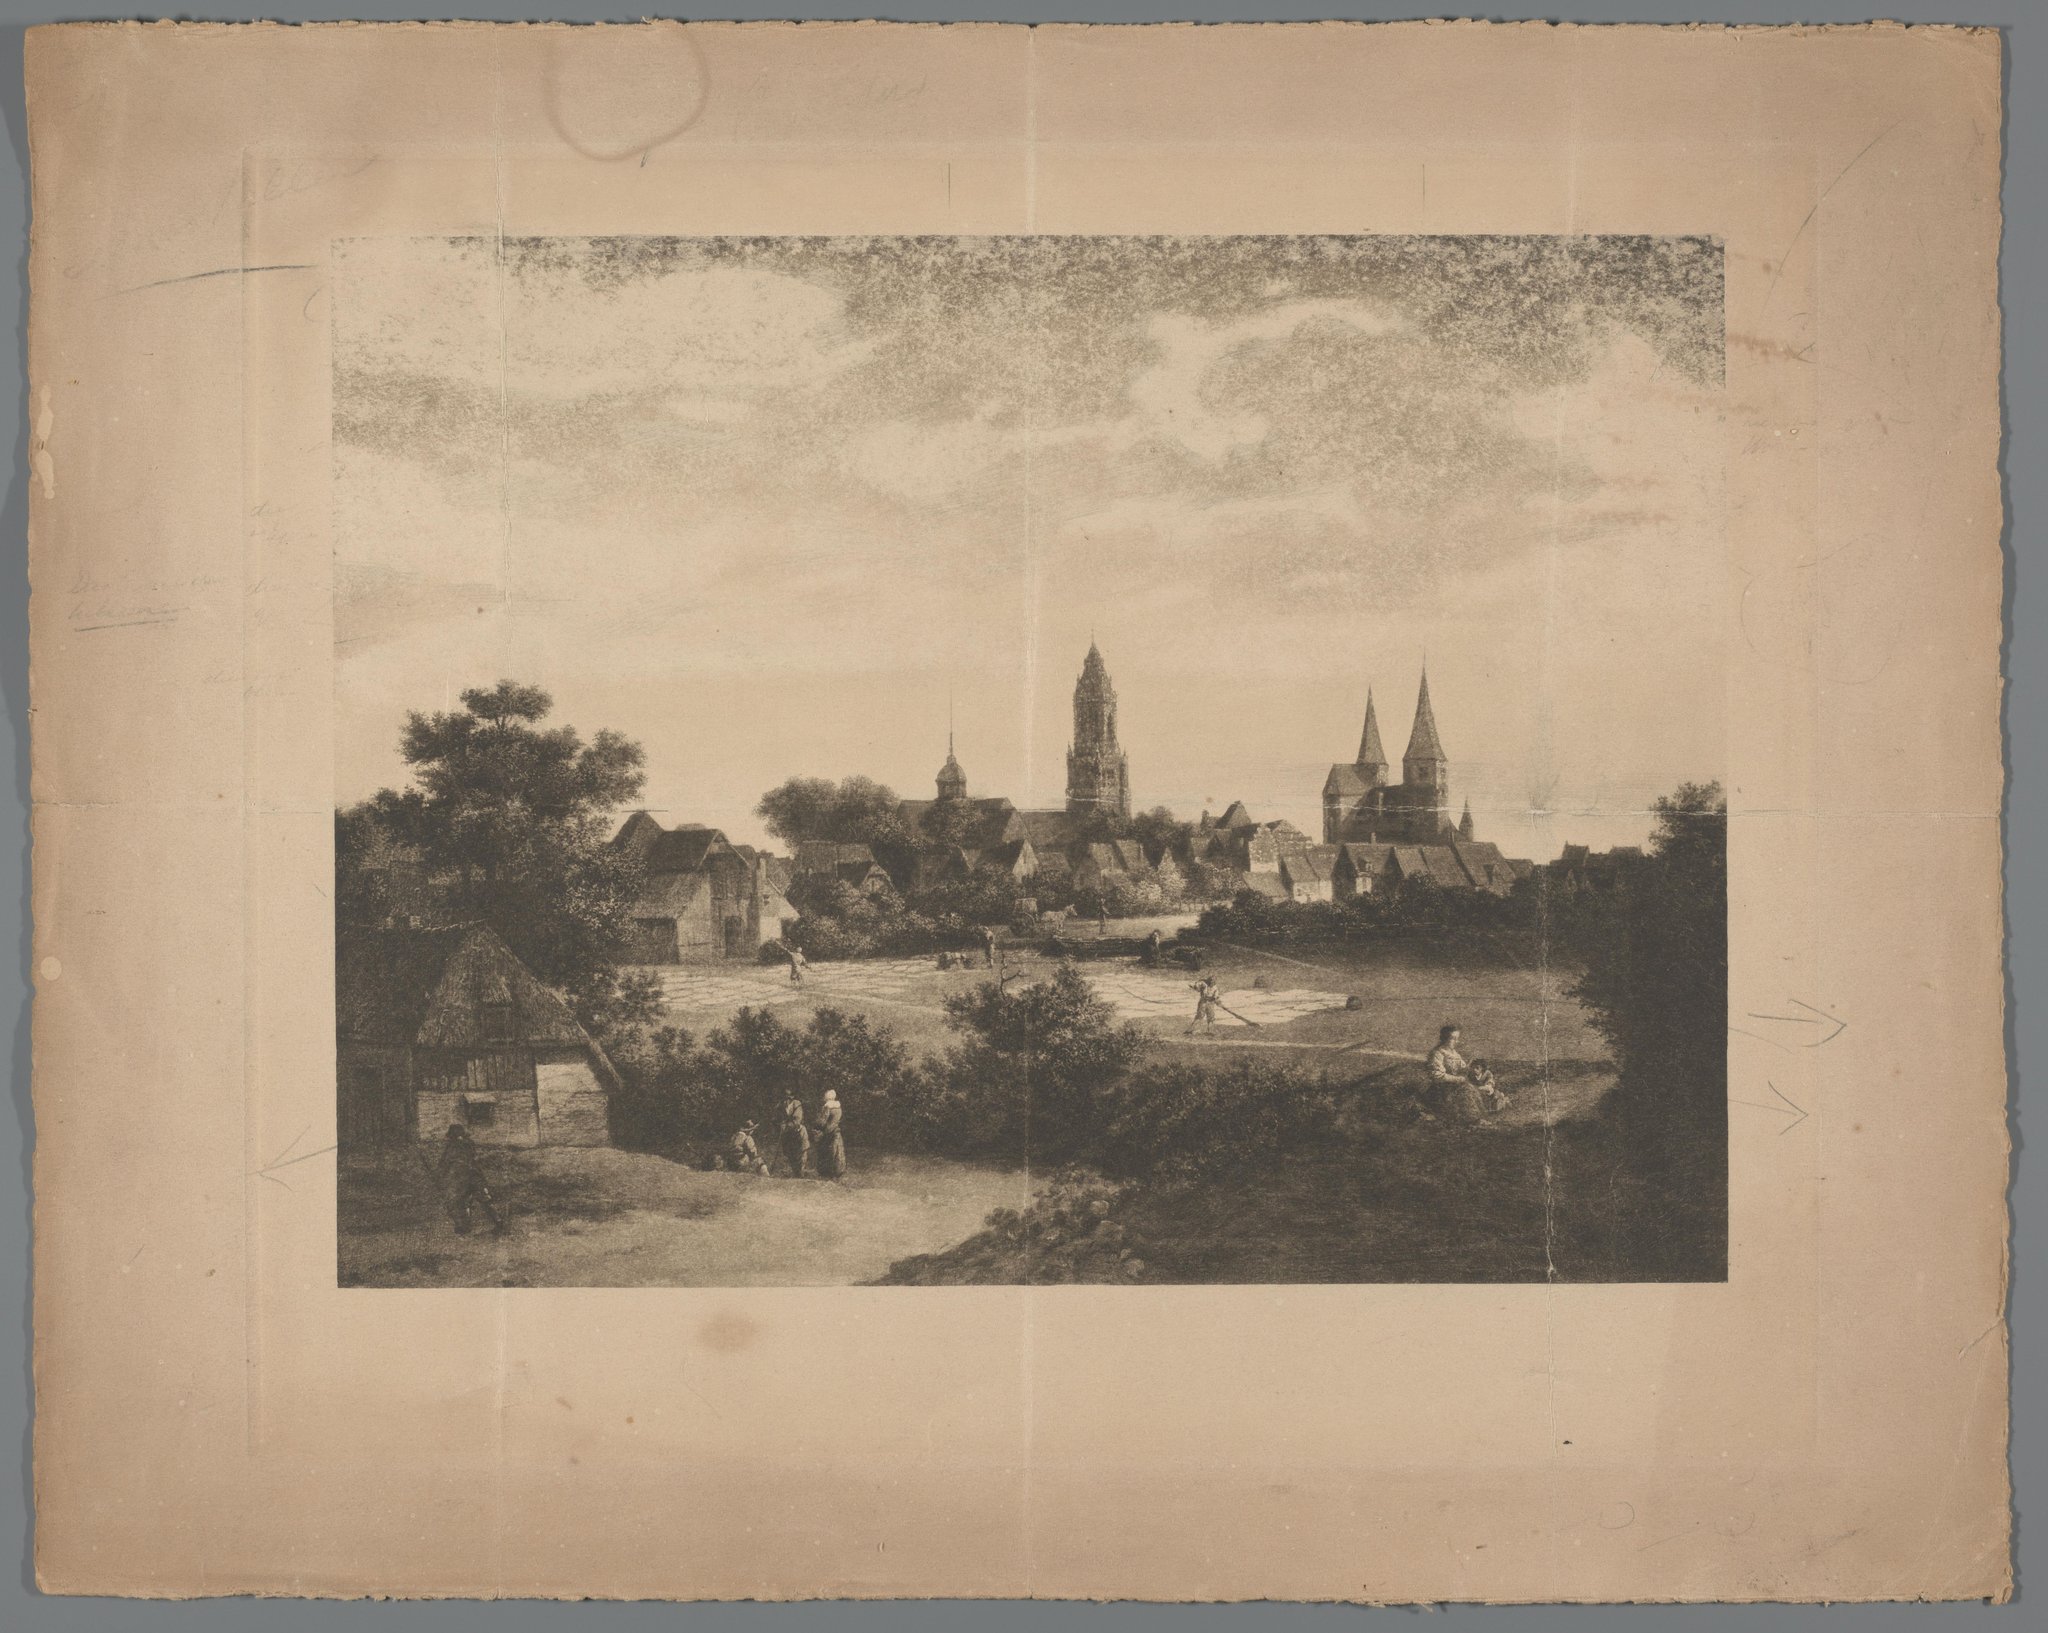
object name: photomechanical print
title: Reproductie van een schilderij met stadsgezicht en een bleekveld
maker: Anonymous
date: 1880-2023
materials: paper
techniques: photoaquatint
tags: bleaching (laundering), prospect of city, town panorama, silhouette of city, parts of church exterior and annexes: tower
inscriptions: inscription: ‘(...)’